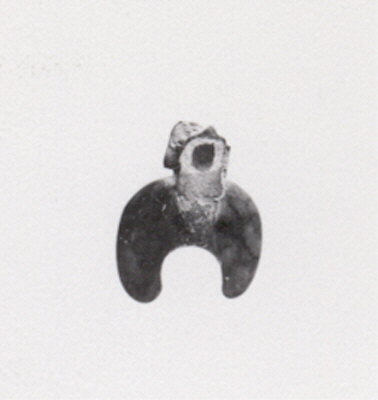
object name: pendant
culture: sasanian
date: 201-700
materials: copper, stone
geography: iran